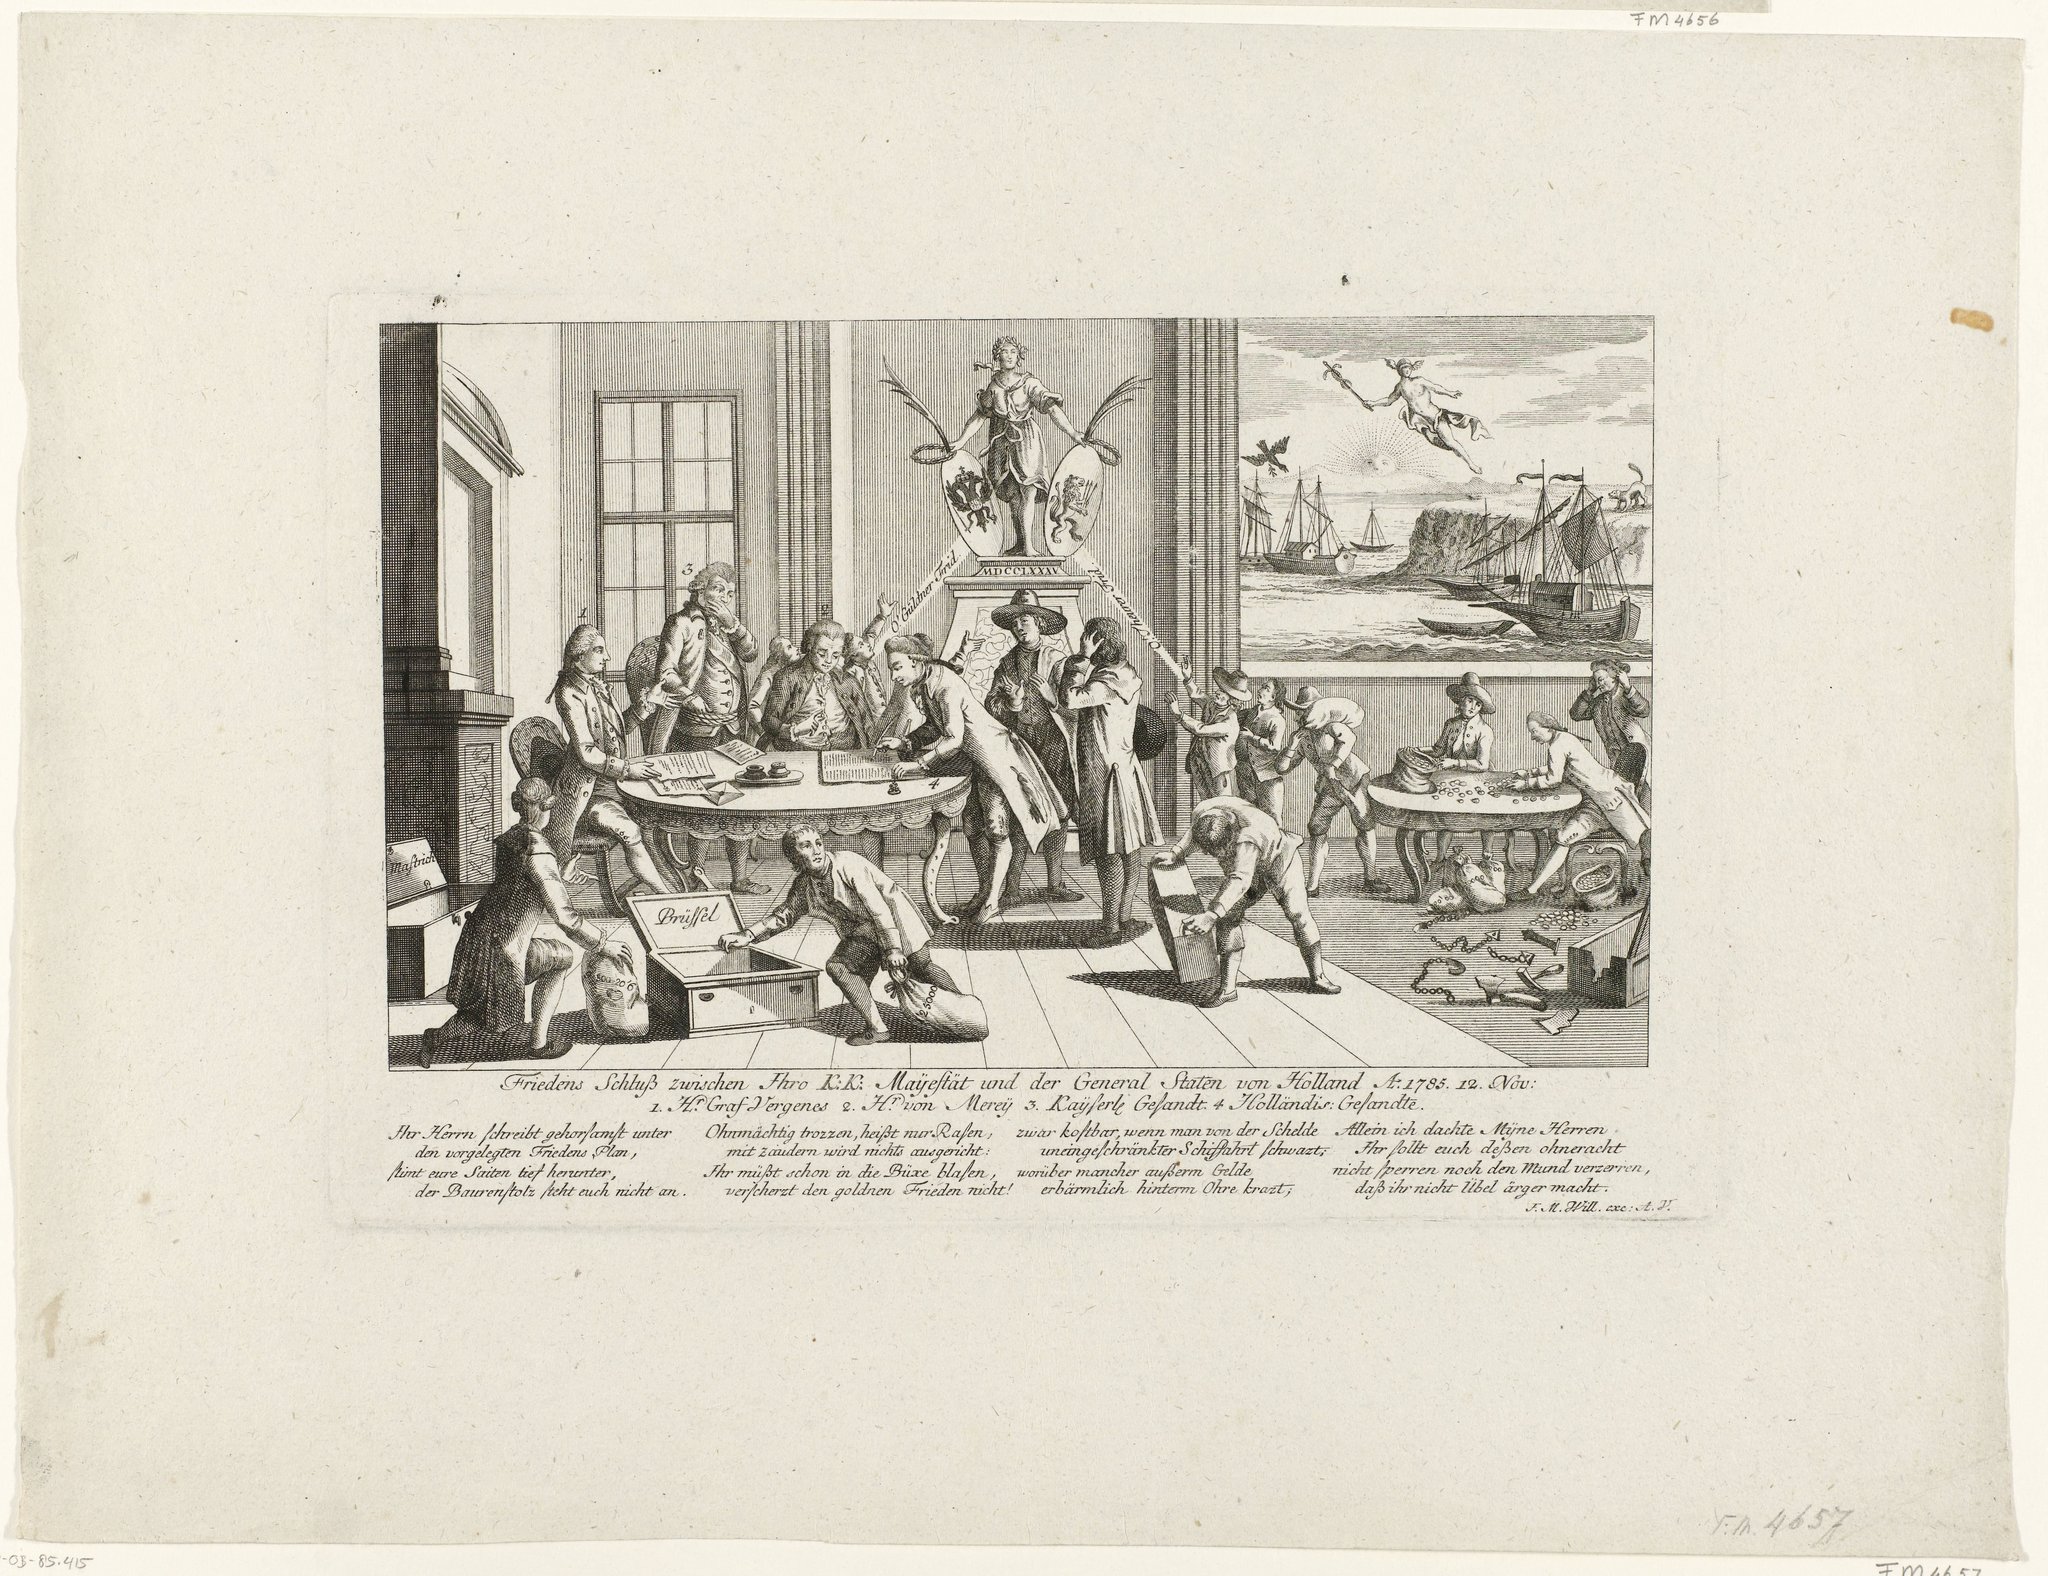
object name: cartoon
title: Spotprent op het Verdrag van Fontainebleau, 1785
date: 1785-1786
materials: paper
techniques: engraving, etching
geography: augsburg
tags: vienna, jozef ii (duits keizer), signing of peace treaty, concluding the peace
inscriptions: collector's mark: Lugt 2228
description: Spotprent op de vrede gesloten te Parijs waarmee een eind kwam aan de Keteloorlog, de twisten tussen Nederland en de Oostenrijkse keizer Jozef II, 10 november 1785. Nederland betaalde 8,5 miljoen gulden en accepteerde andere vernederende voorwaarden. De Hollandse gezant ondertekent de acte tot tevredenheid van de keizer en andere buitenlandse vertegenwoordigers. Het door Nederland betaalde geld wordt in zakken naar de lege geldkisten gesleept. In het onderschrift vier vierregelige verzen in het Duits.